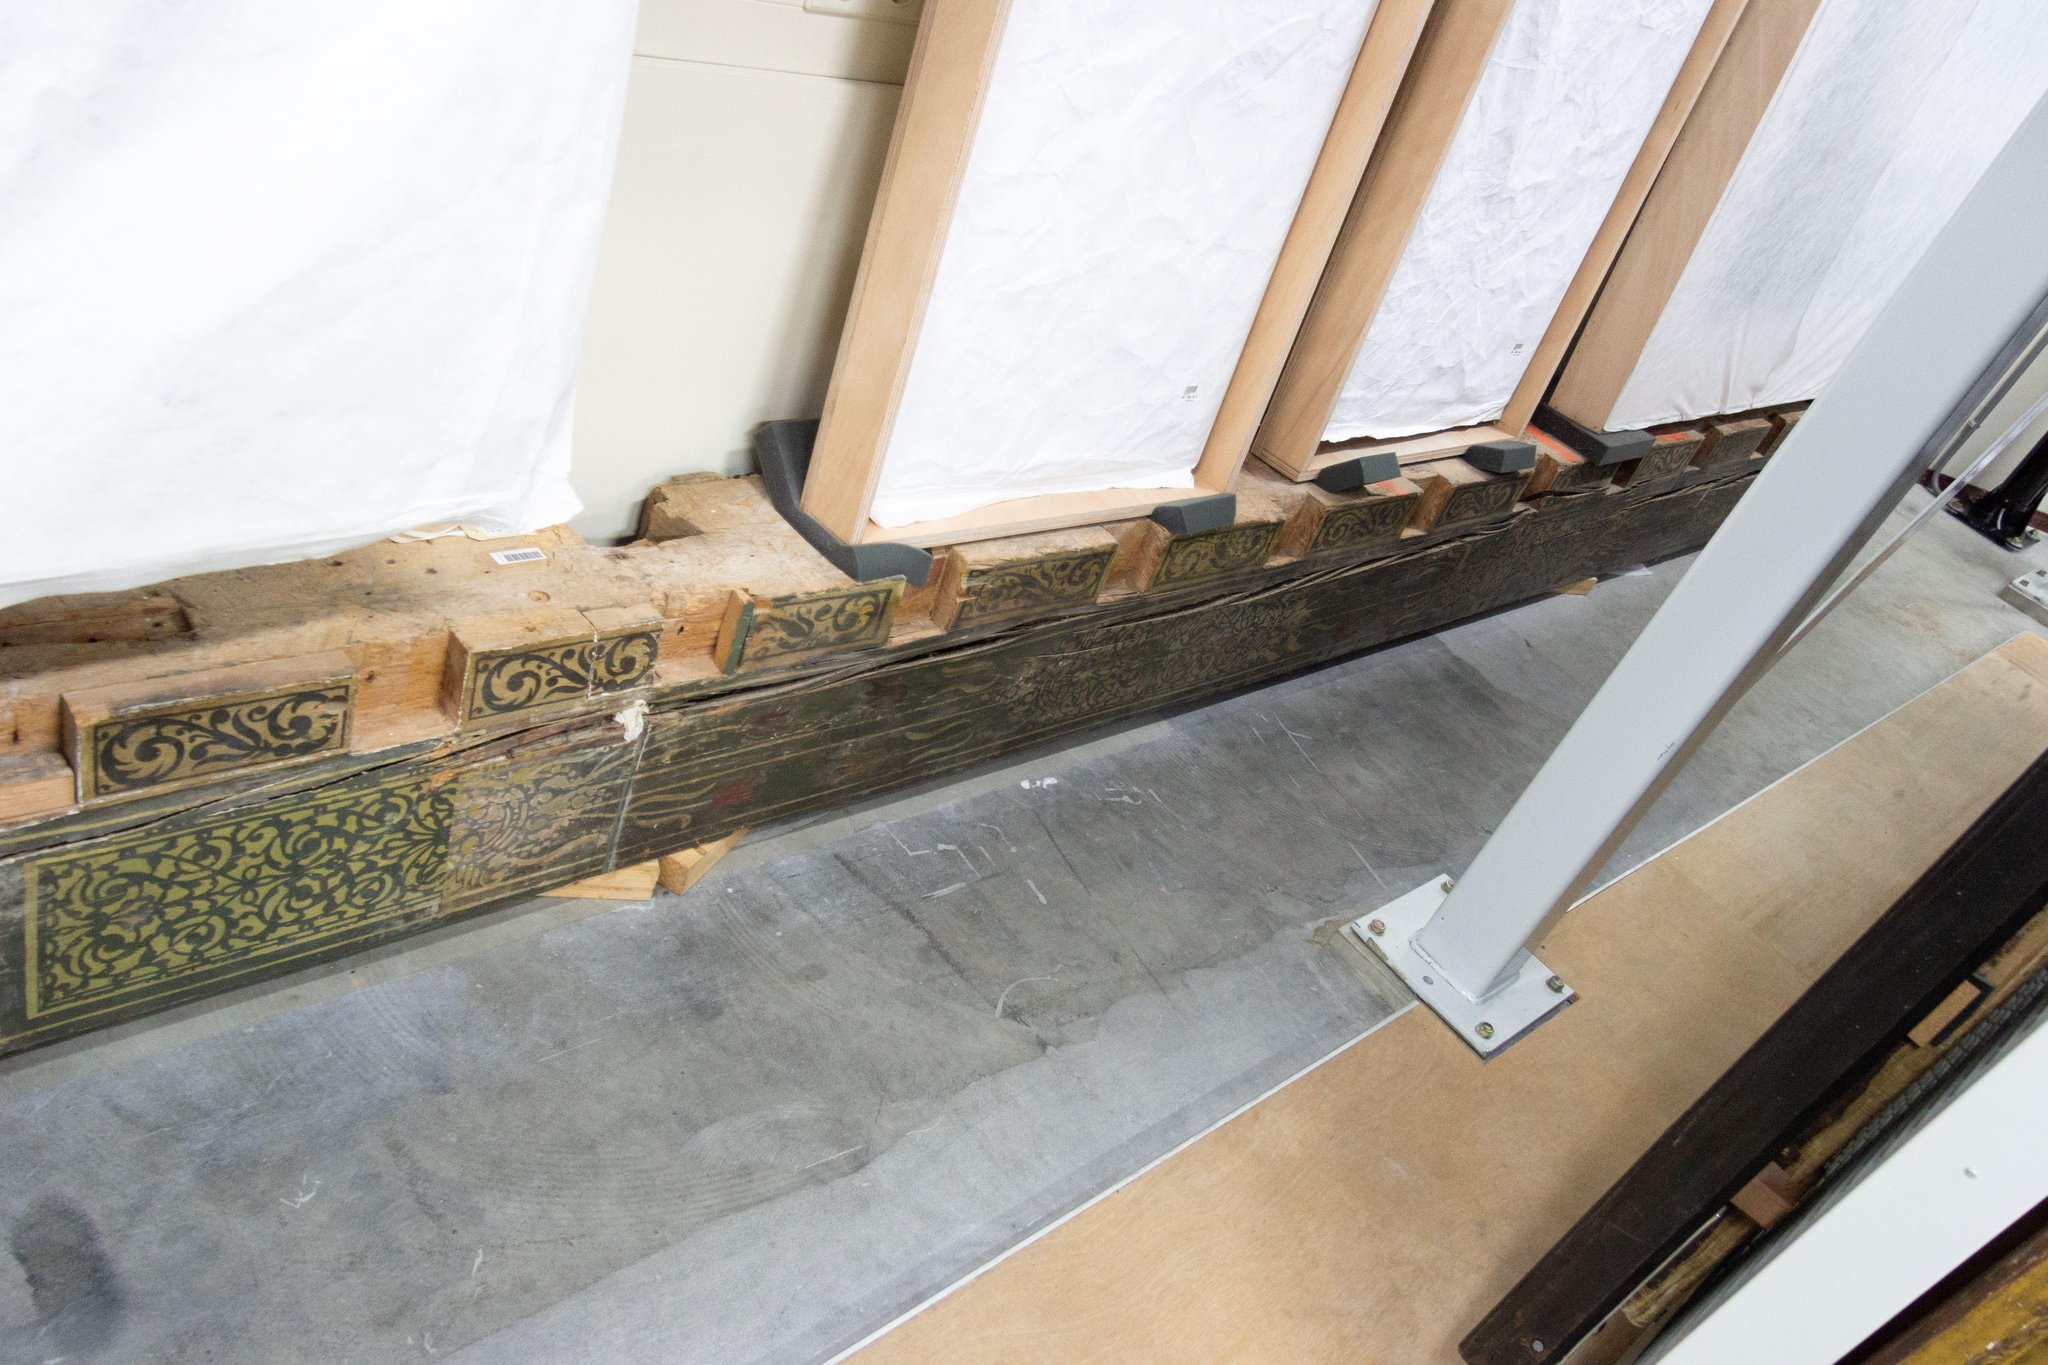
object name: ceiling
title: Moerbalk van beschilderd eikenhout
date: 1631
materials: wood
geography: northern netherlands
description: Moerbalk van geschilderd eikenhout. Horend bij een balkenzoldering afkomstig uit het huis De Munnik, Wijnstraat 54, Dordrecht.